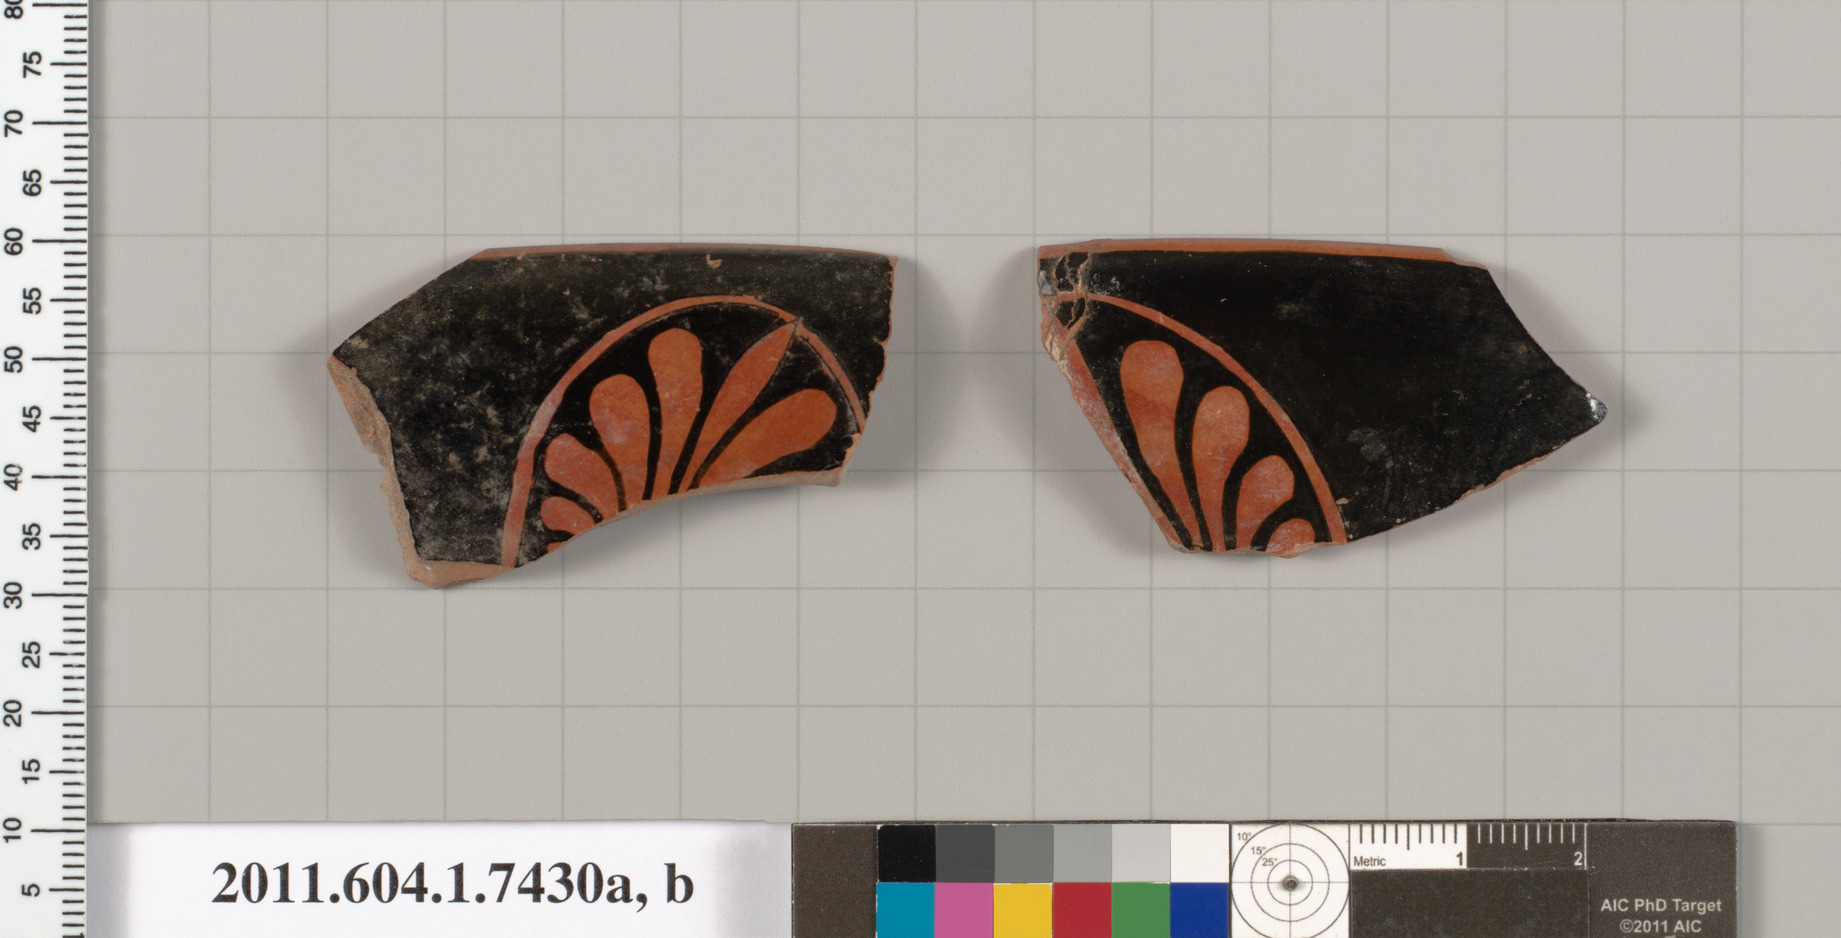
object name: kylix fragment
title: Terracotta rim fragments of kylikes (drinking cups)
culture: greek, attic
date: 490-470 BCE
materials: terracotta